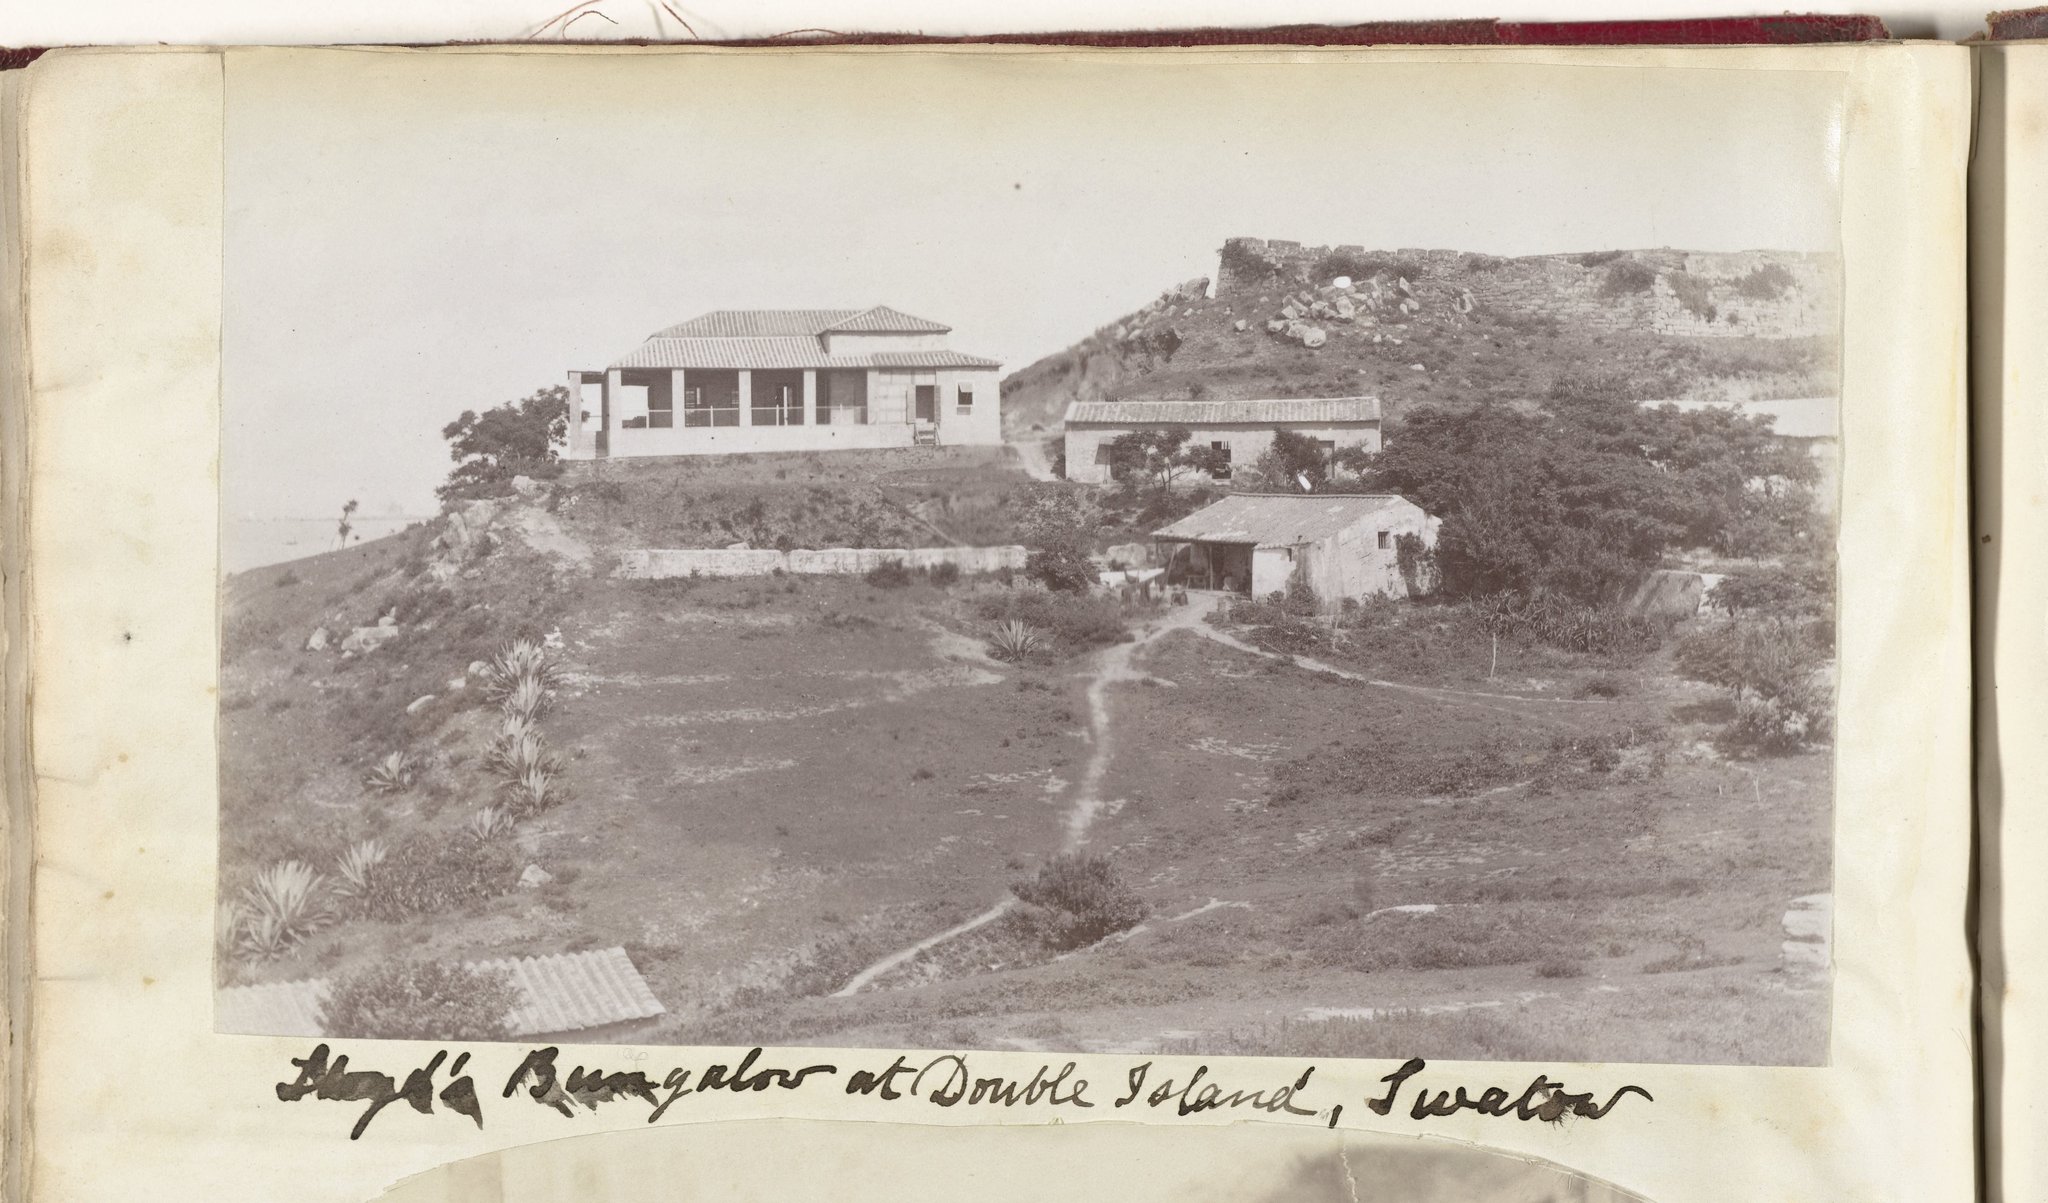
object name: photograph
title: Lloyd's Bungalow at Double Island, Swatow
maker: Anonymous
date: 1879-1890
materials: paper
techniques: albumen print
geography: shantou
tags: rural housing, e.g. country-house, villa, cottage, shantou